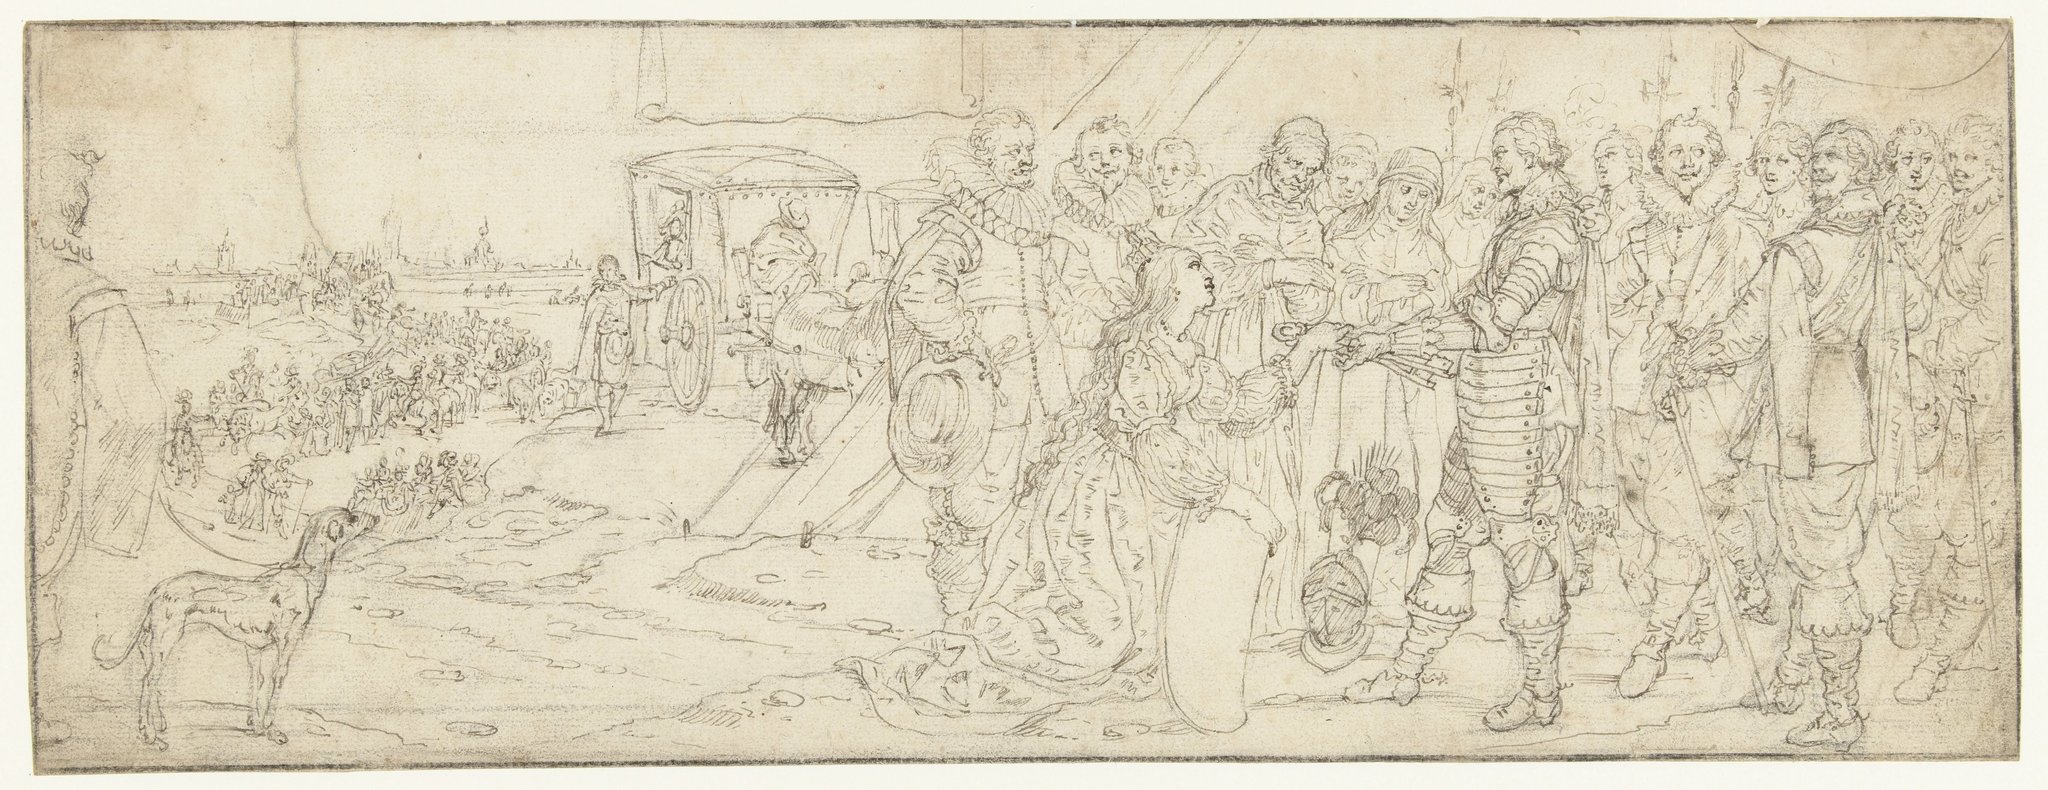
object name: drawing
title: Stedenmaagd van Den Bosch en prins Frederik Hendrik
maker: crispijn van de passe (i)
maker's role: draughtsman, print maker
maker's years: 1564-1637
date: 1629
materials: chalk, ink, paper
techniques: pen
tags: frederick henry (prince of orange), surrender of keys, den bosch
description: De Stedenmaagd van Den Bosch presenteert de sleutels van de stad aan prins Frederik Hendrik in 1629. Ontwerp voor een prent.